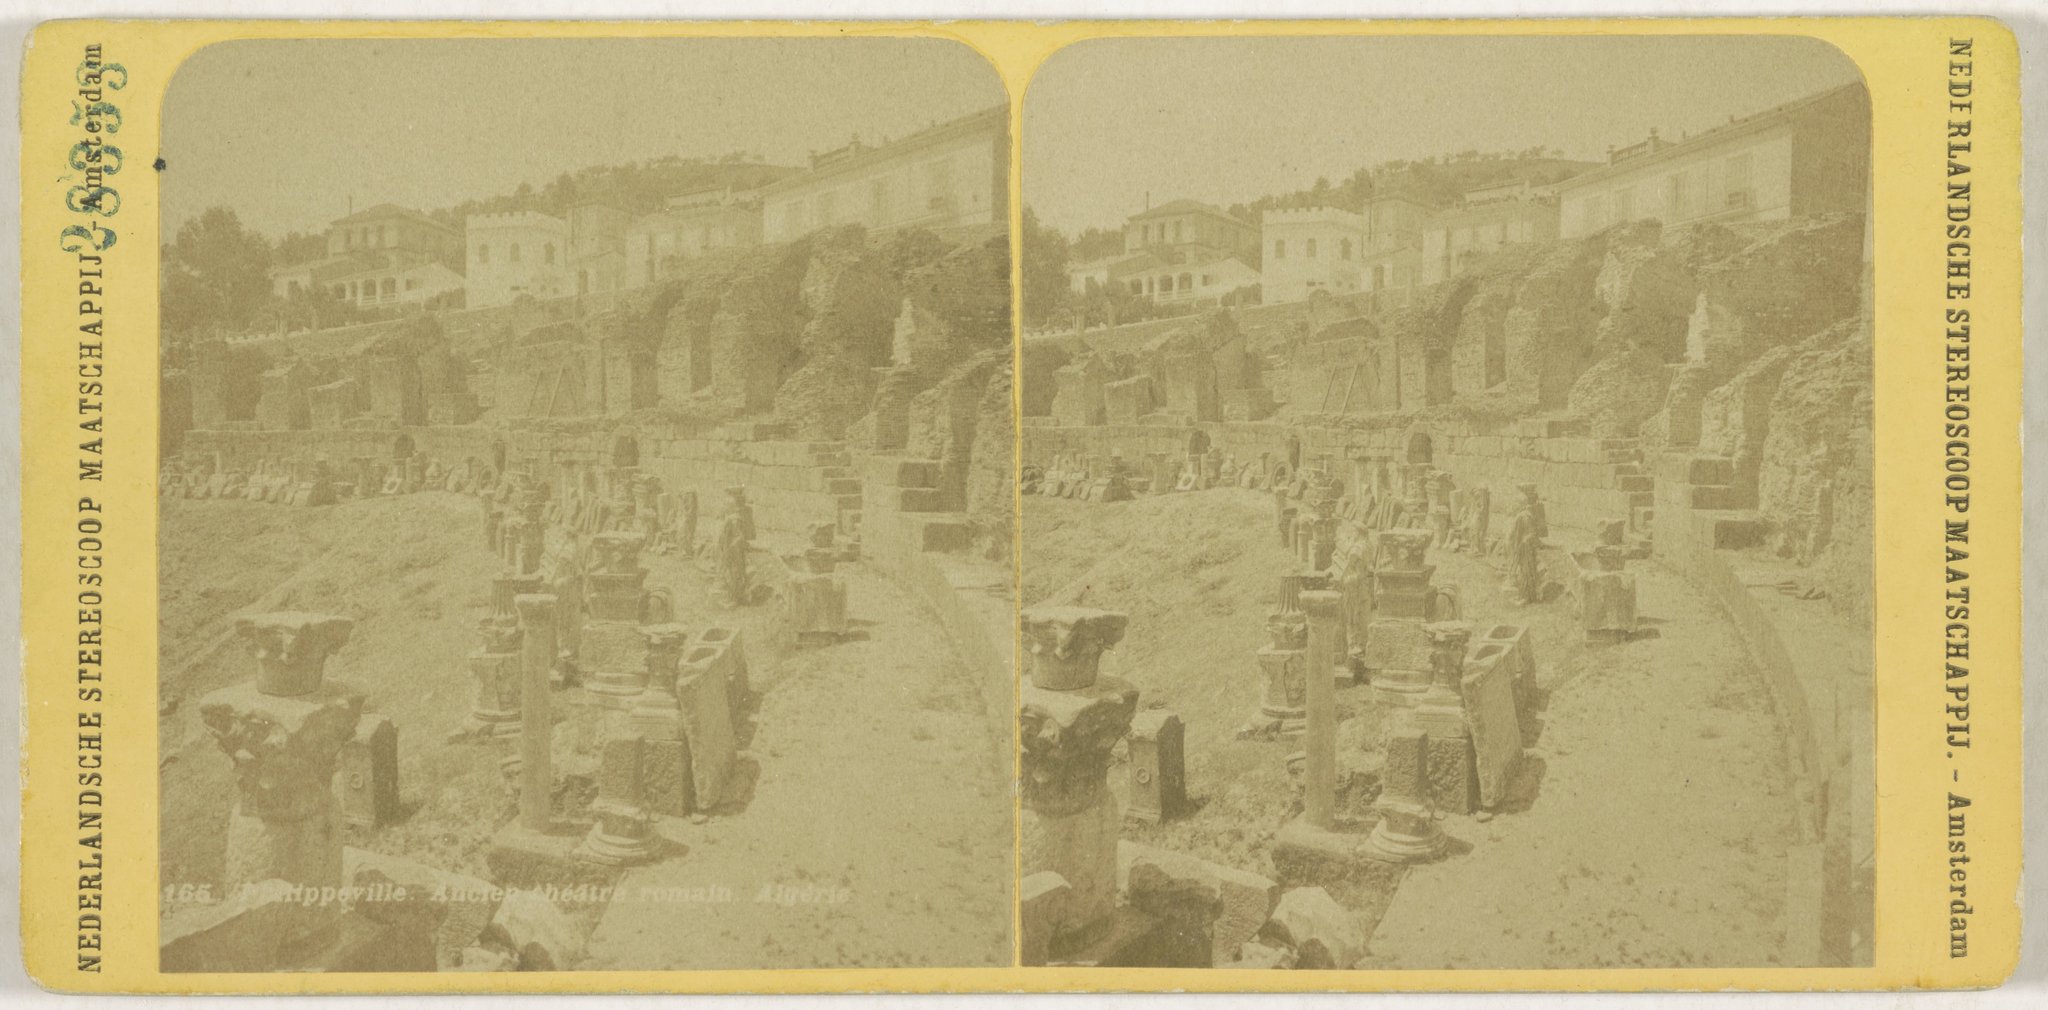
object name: stereograph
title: Philippeville. Ancien théatre romain. Algérie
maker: j.g. beers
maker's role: fotograaf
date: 1868-1890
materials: cardboard, paper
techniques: albumen print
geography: skikda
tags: ruin of a building ~ architecture, amphitheatre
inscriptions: number: ‘165’, number: ‘28353’